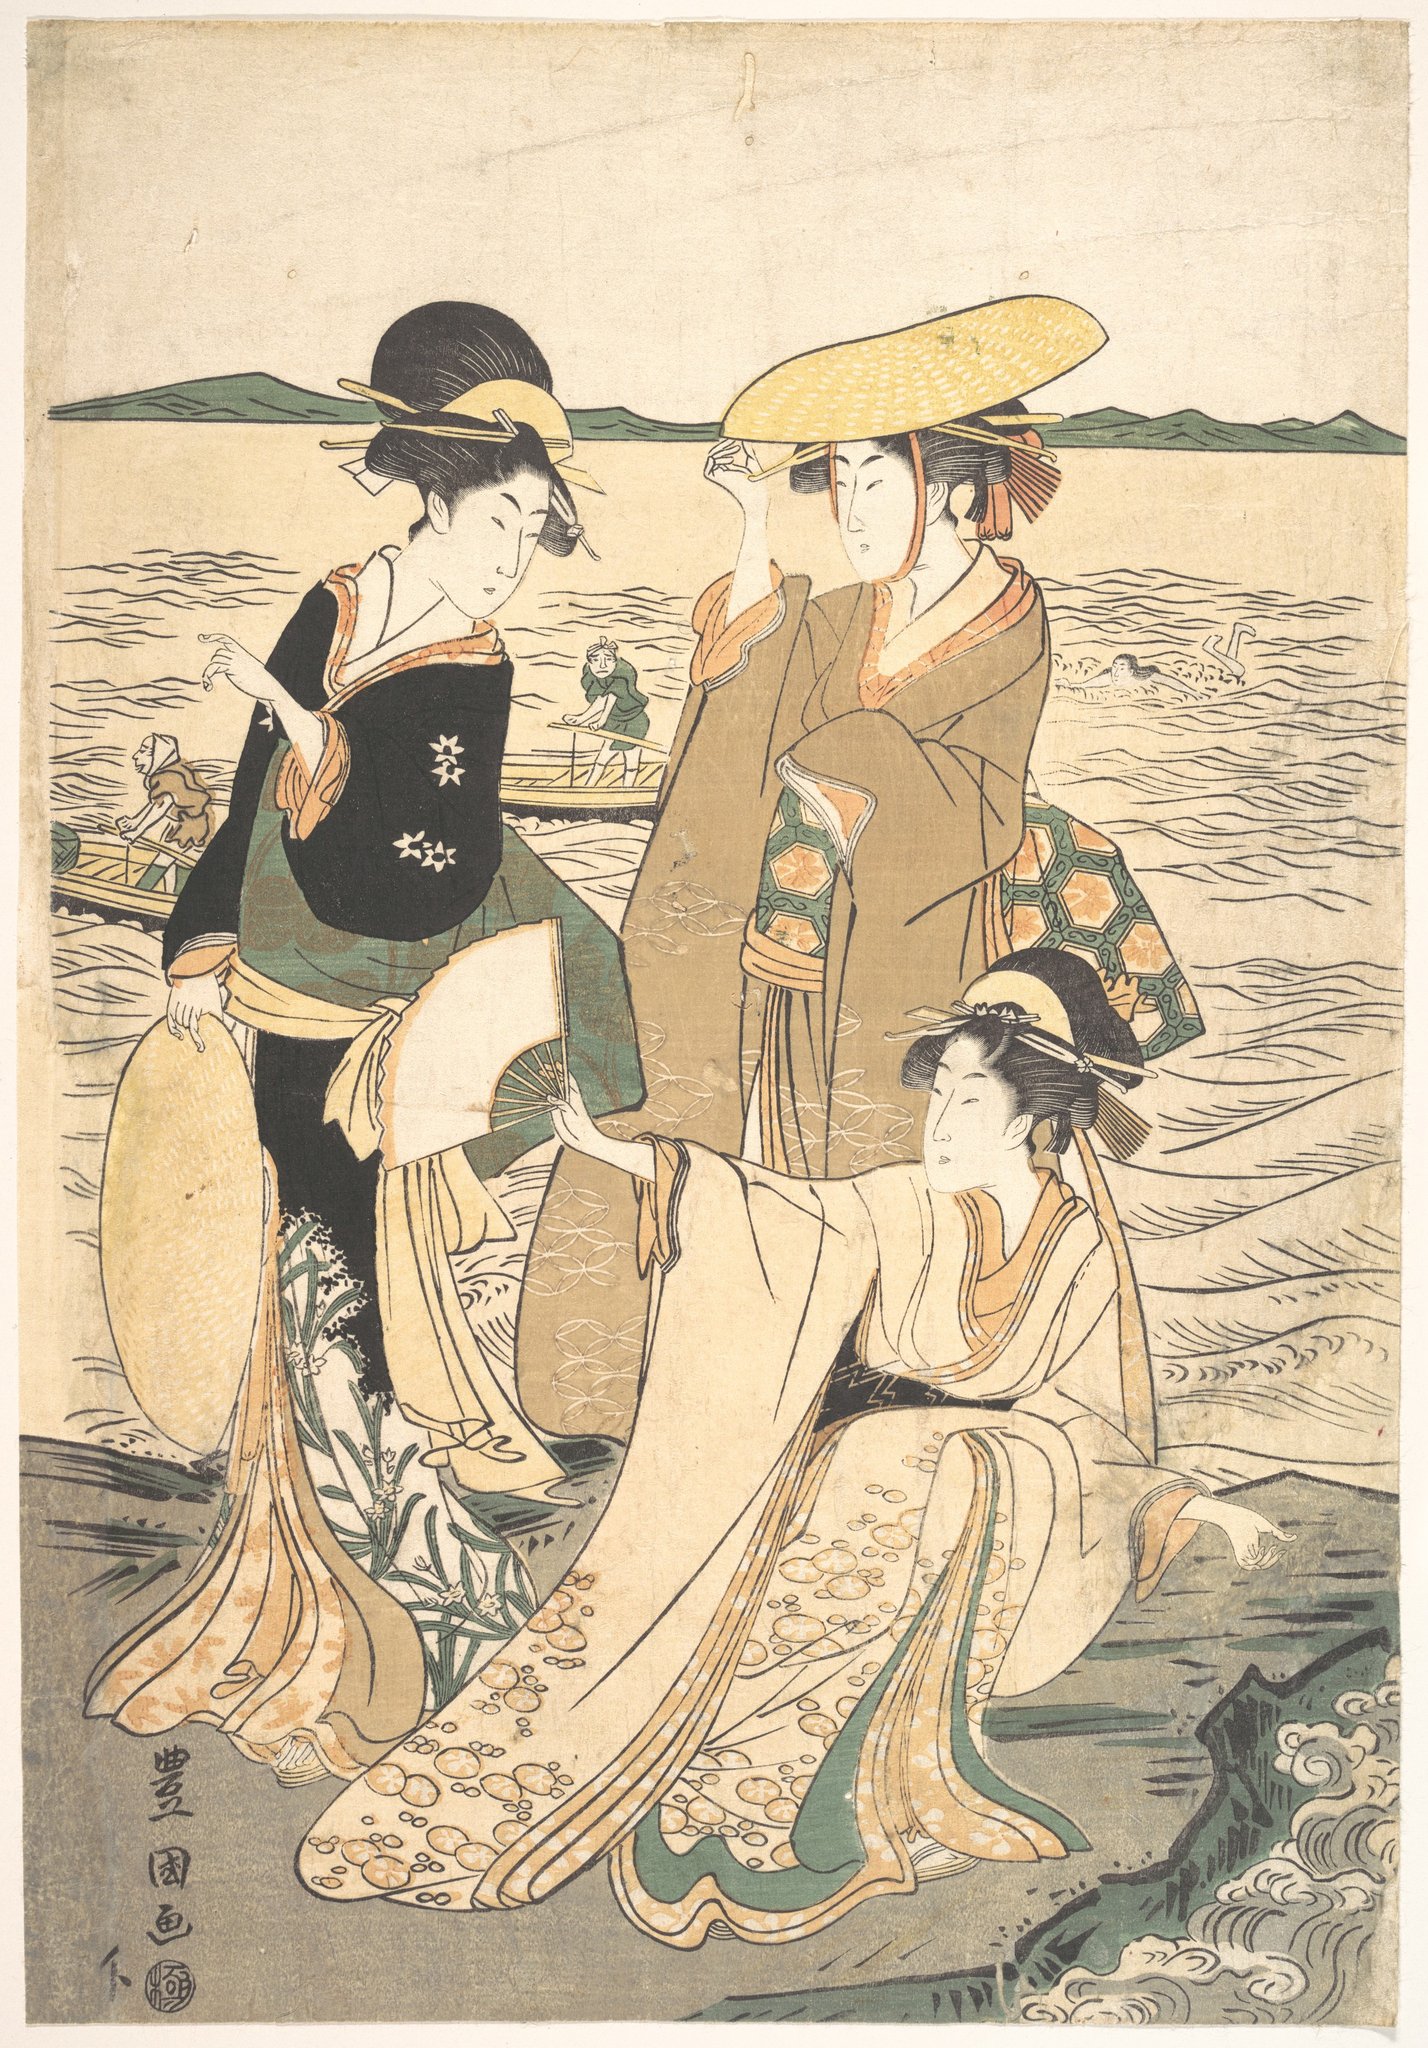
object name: print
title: Three Young Ladies by the Seashore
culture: japanese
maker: utagawa toyokuni i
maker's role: artist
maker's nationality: japanese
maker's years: 1769-1825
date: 1769-1825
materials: ink, paper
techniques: woodblock print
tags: women,mountains,seascapes,boats